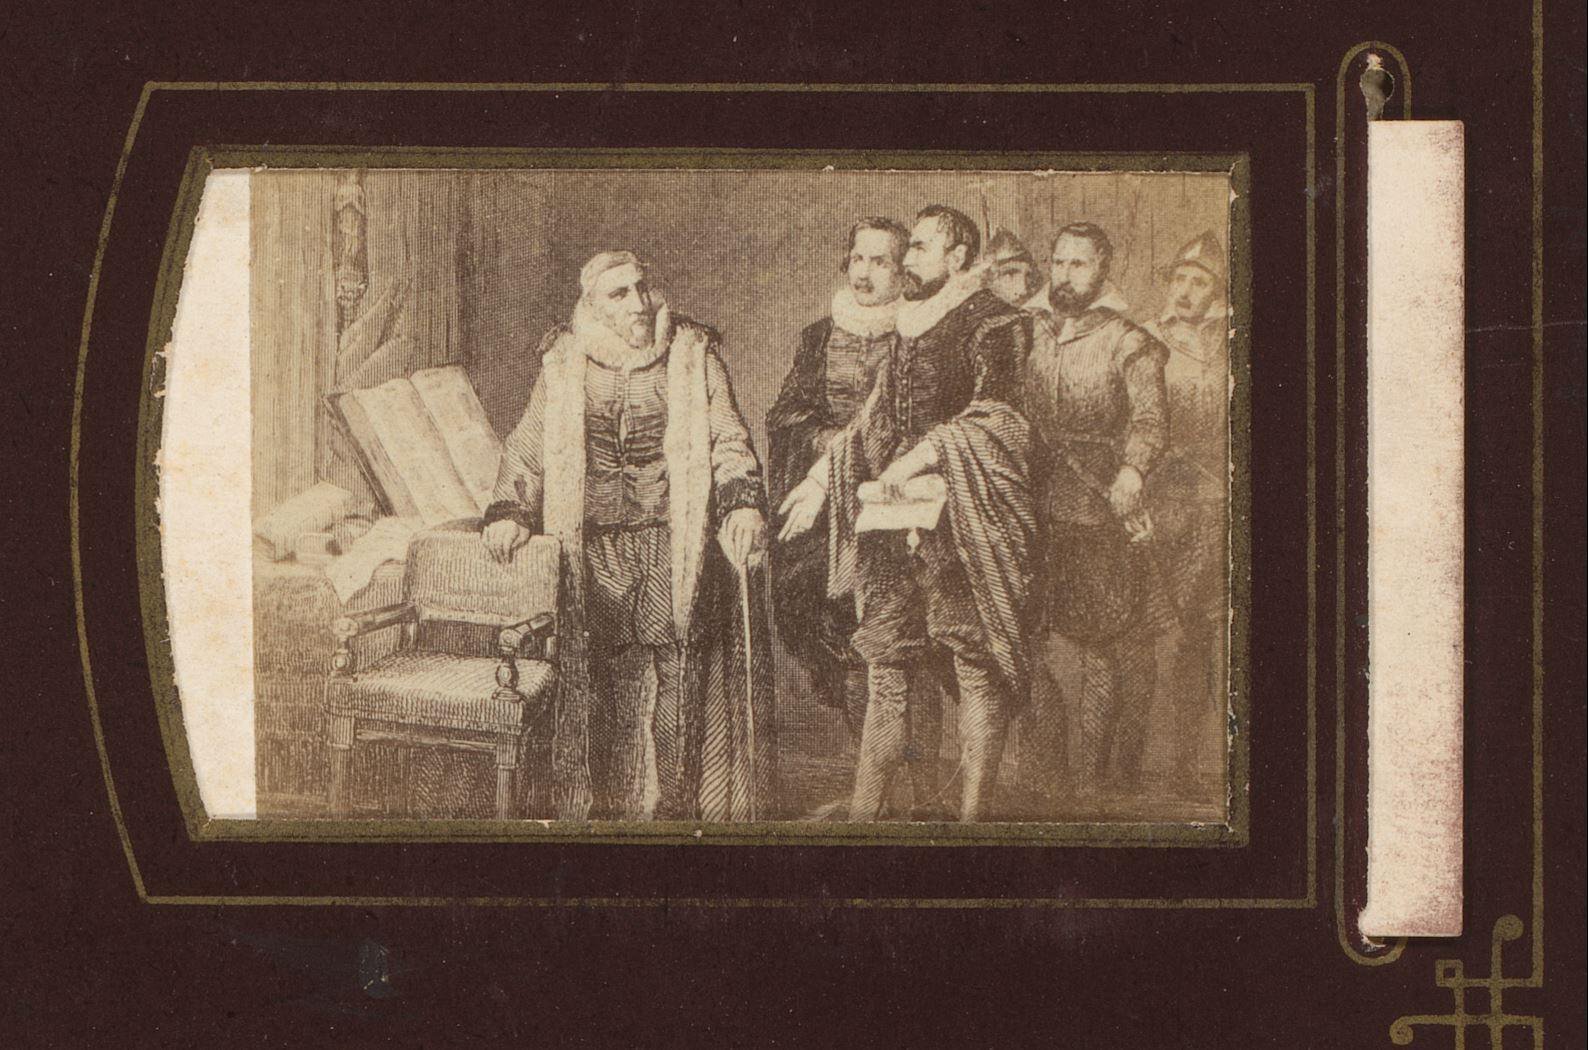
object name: reproduction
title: Fotoreproductie van een gravure van Johan van Oldenbarnevelt die zijn vonnis voorgelezen krijgt op 12 mei 1619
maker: Anonymous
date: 1850-1900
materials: cardboard, photographic support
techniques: albumen print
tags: johan van oldenbarnevelt, judicial verdict, netherlands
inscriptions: inscription: ‘43./ Oldenbarneveld wordt (...) te geven."’